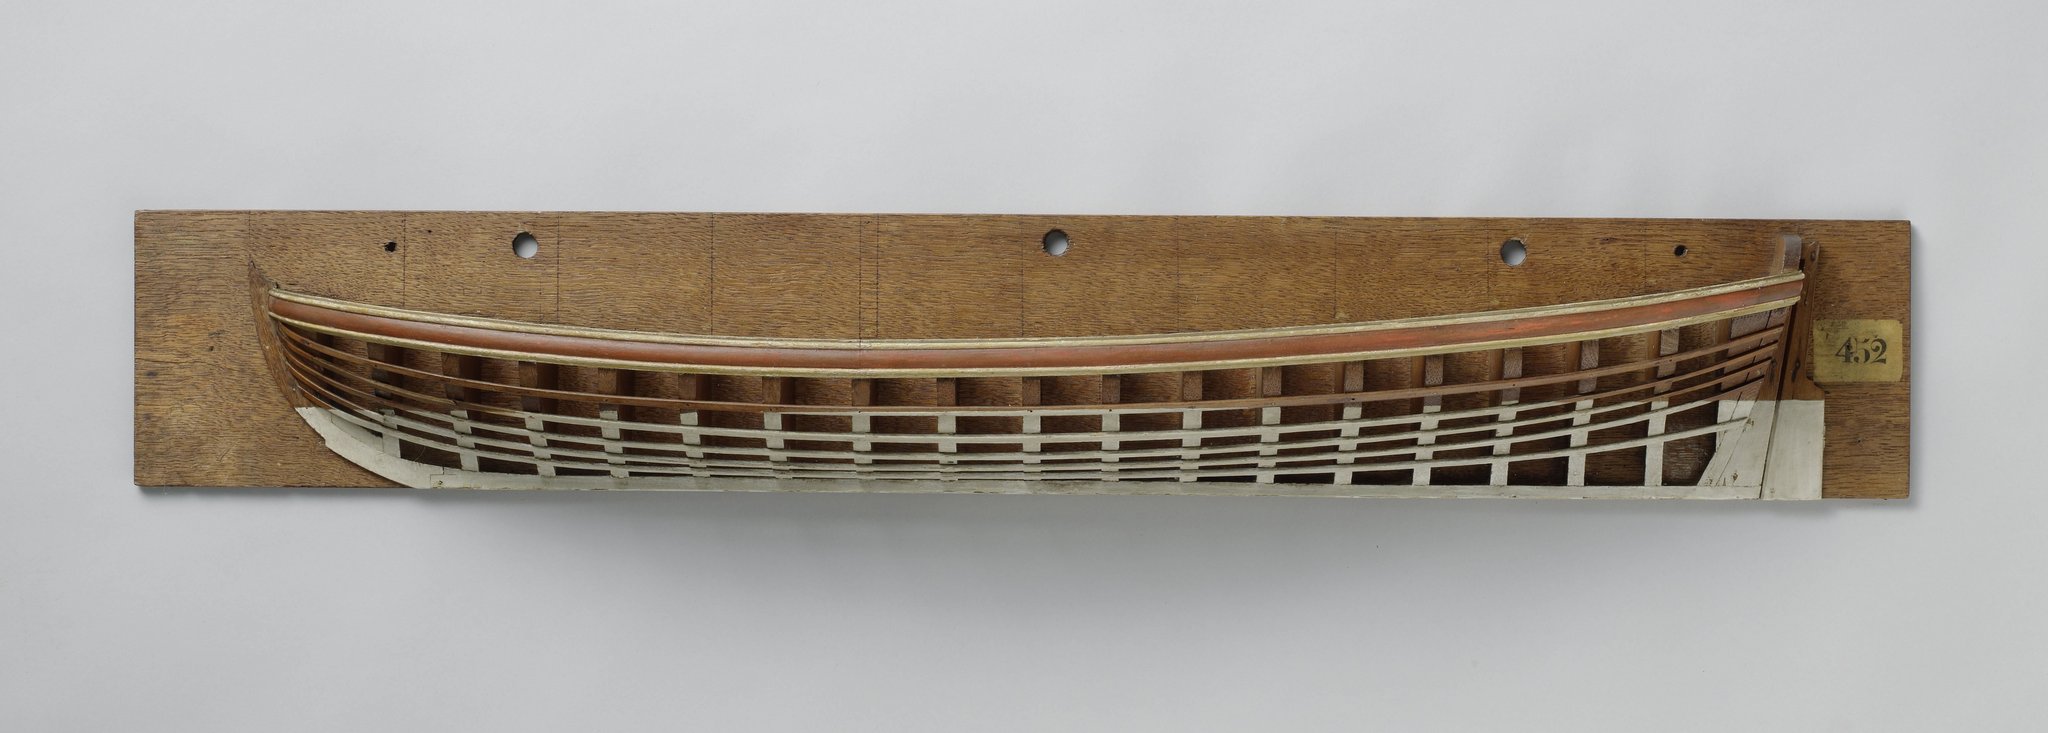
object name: half model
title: Half Model of a Launch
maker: Anonymous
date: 1780-1820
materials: wood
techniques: polychromy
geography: netherlands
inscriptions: label, centre right: ‘452’ former inventory label